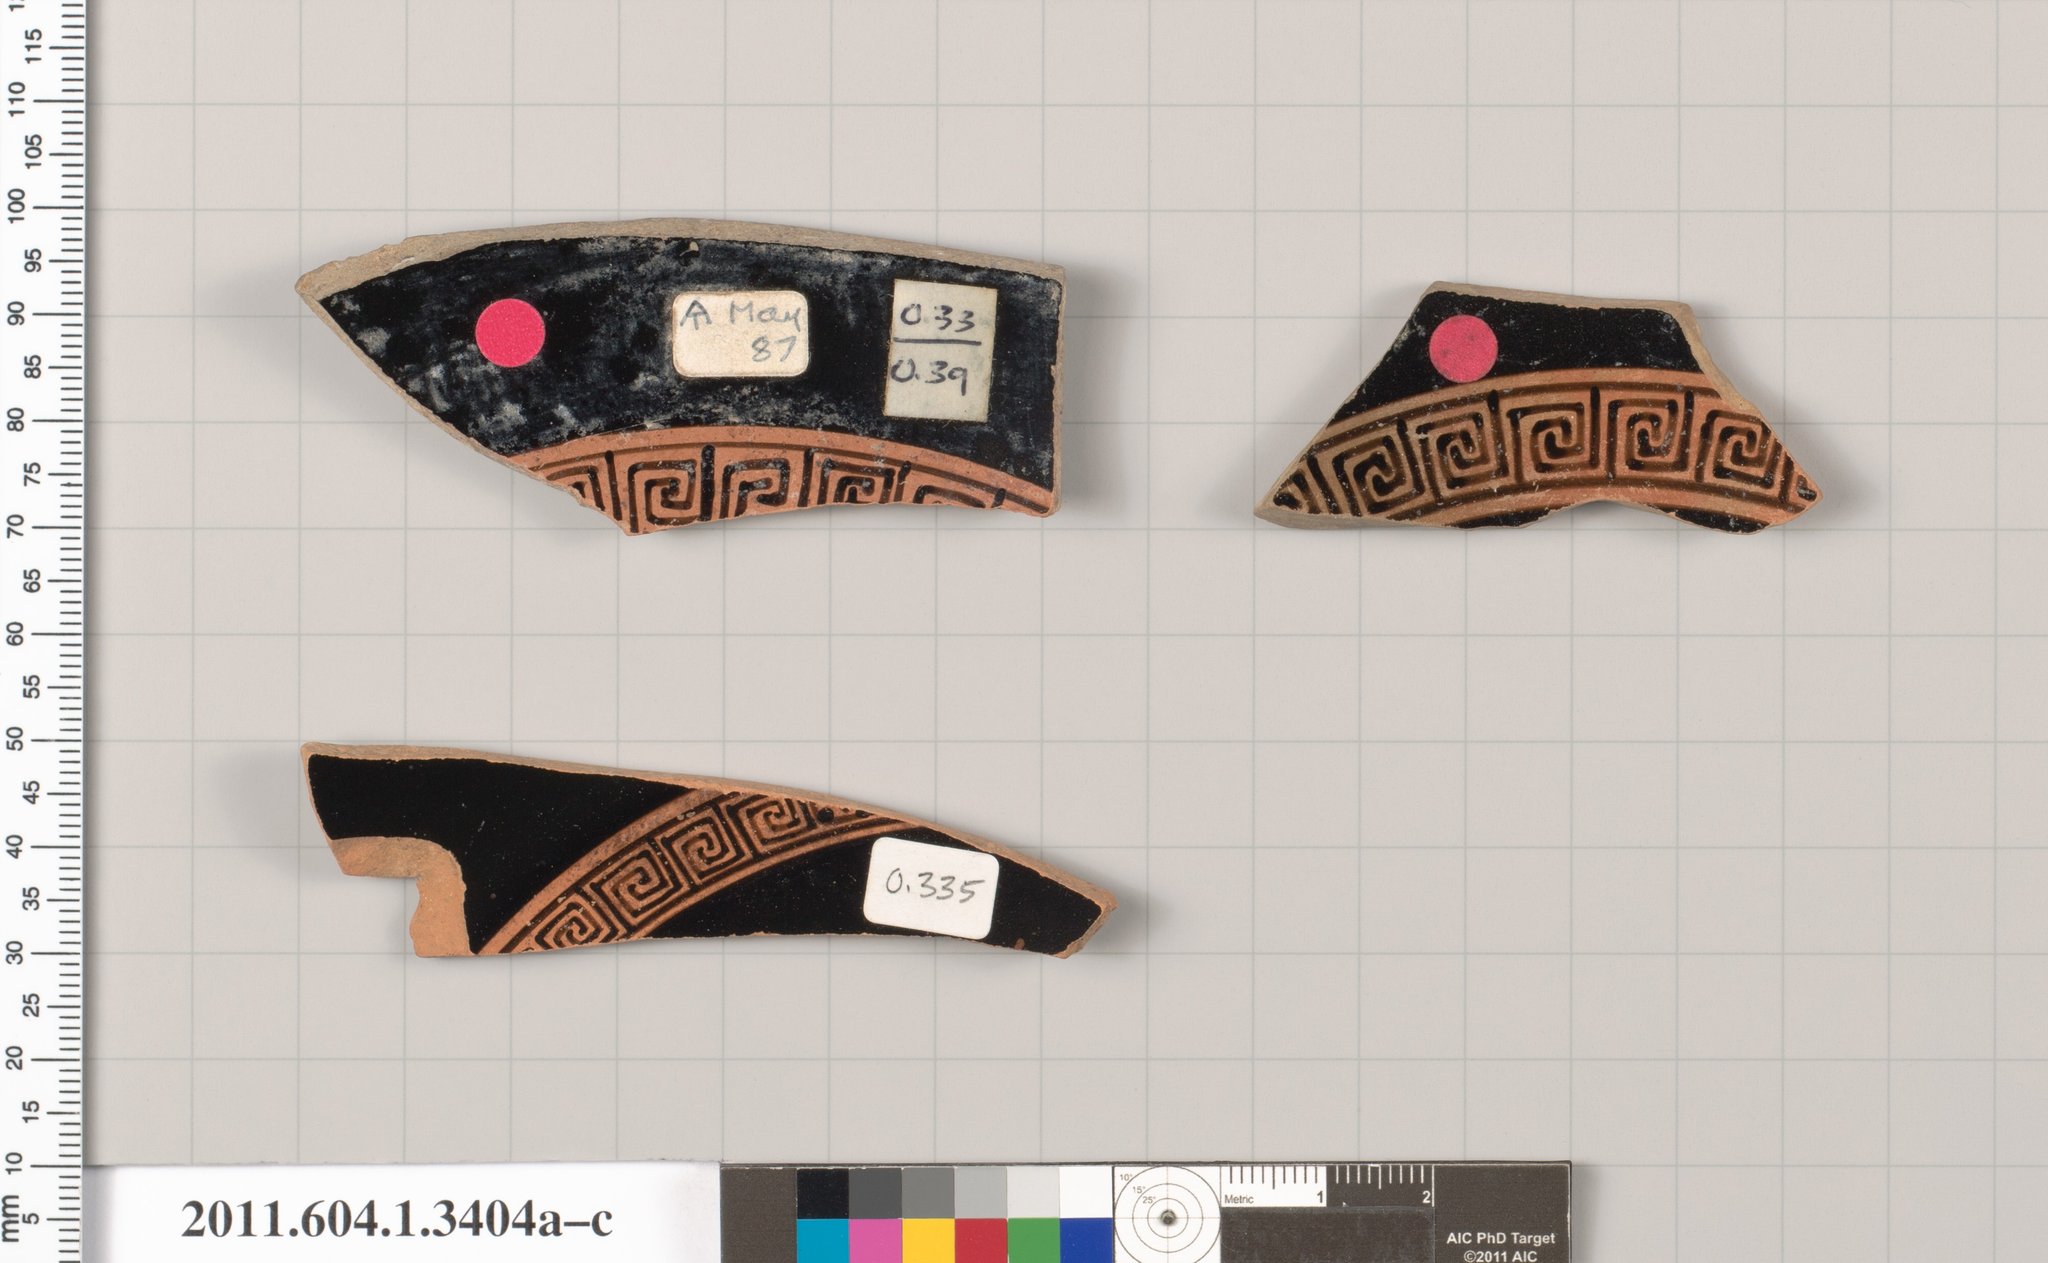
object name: kylix fragment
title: Terracotta fragments of kylikes (drinking cups)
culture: greek, attic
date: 510-470 BCE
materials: terracotta